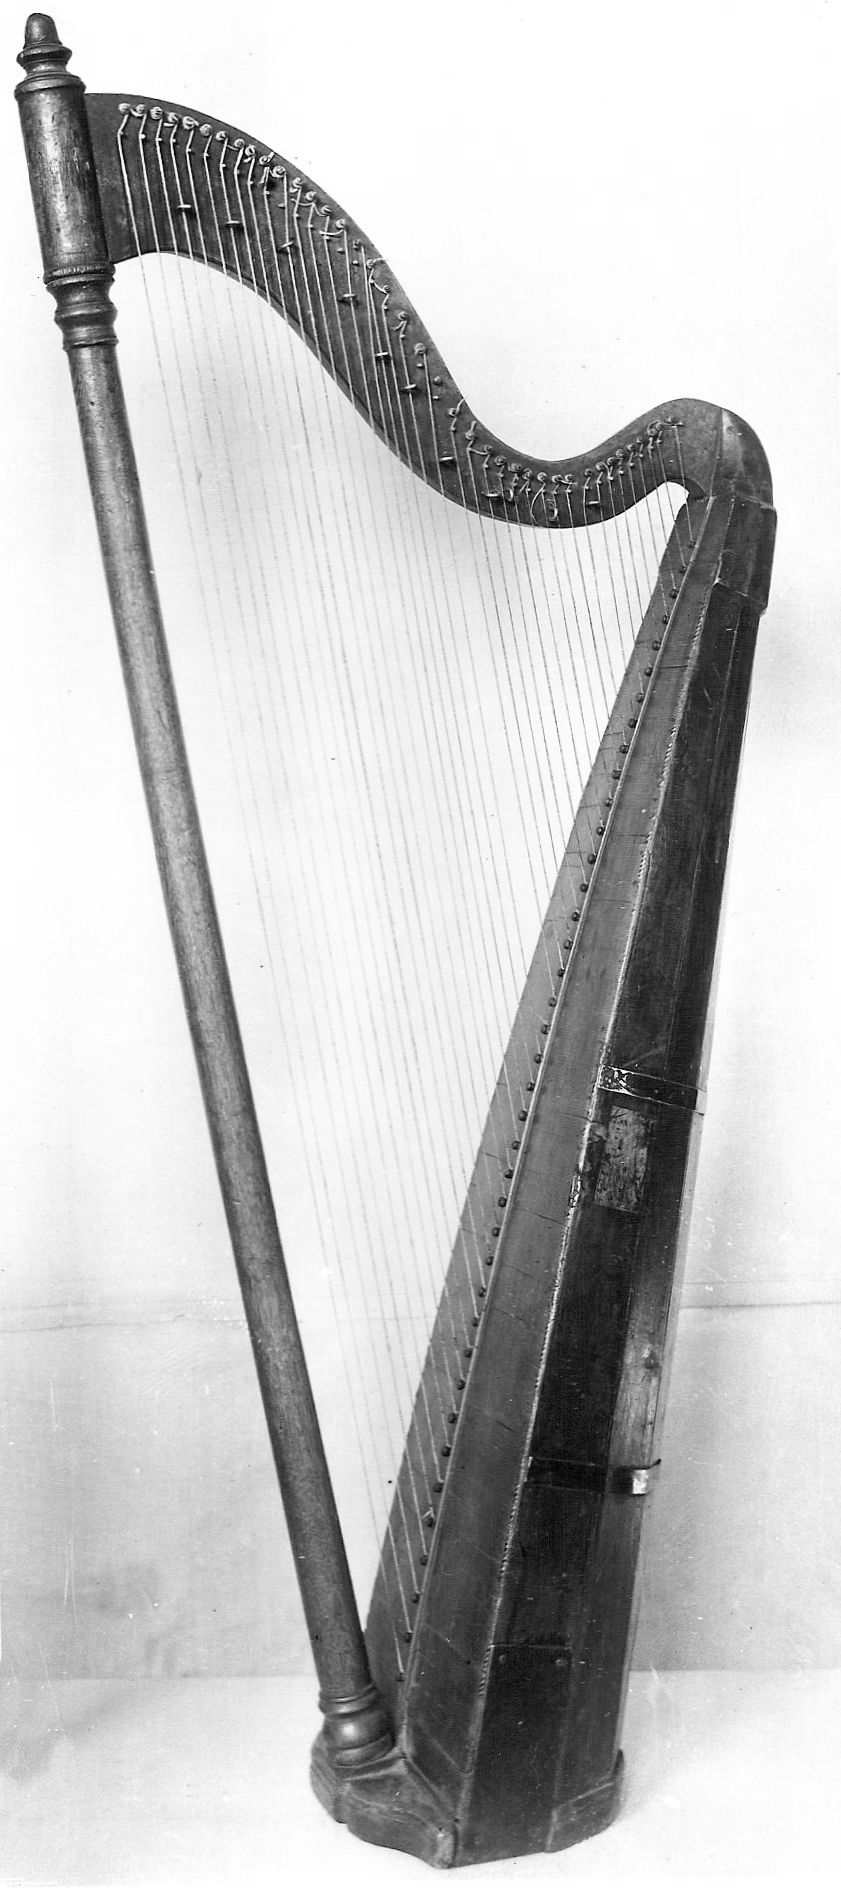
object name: hooked harp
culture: german or austrian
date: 1801-1833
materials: wood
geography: germany